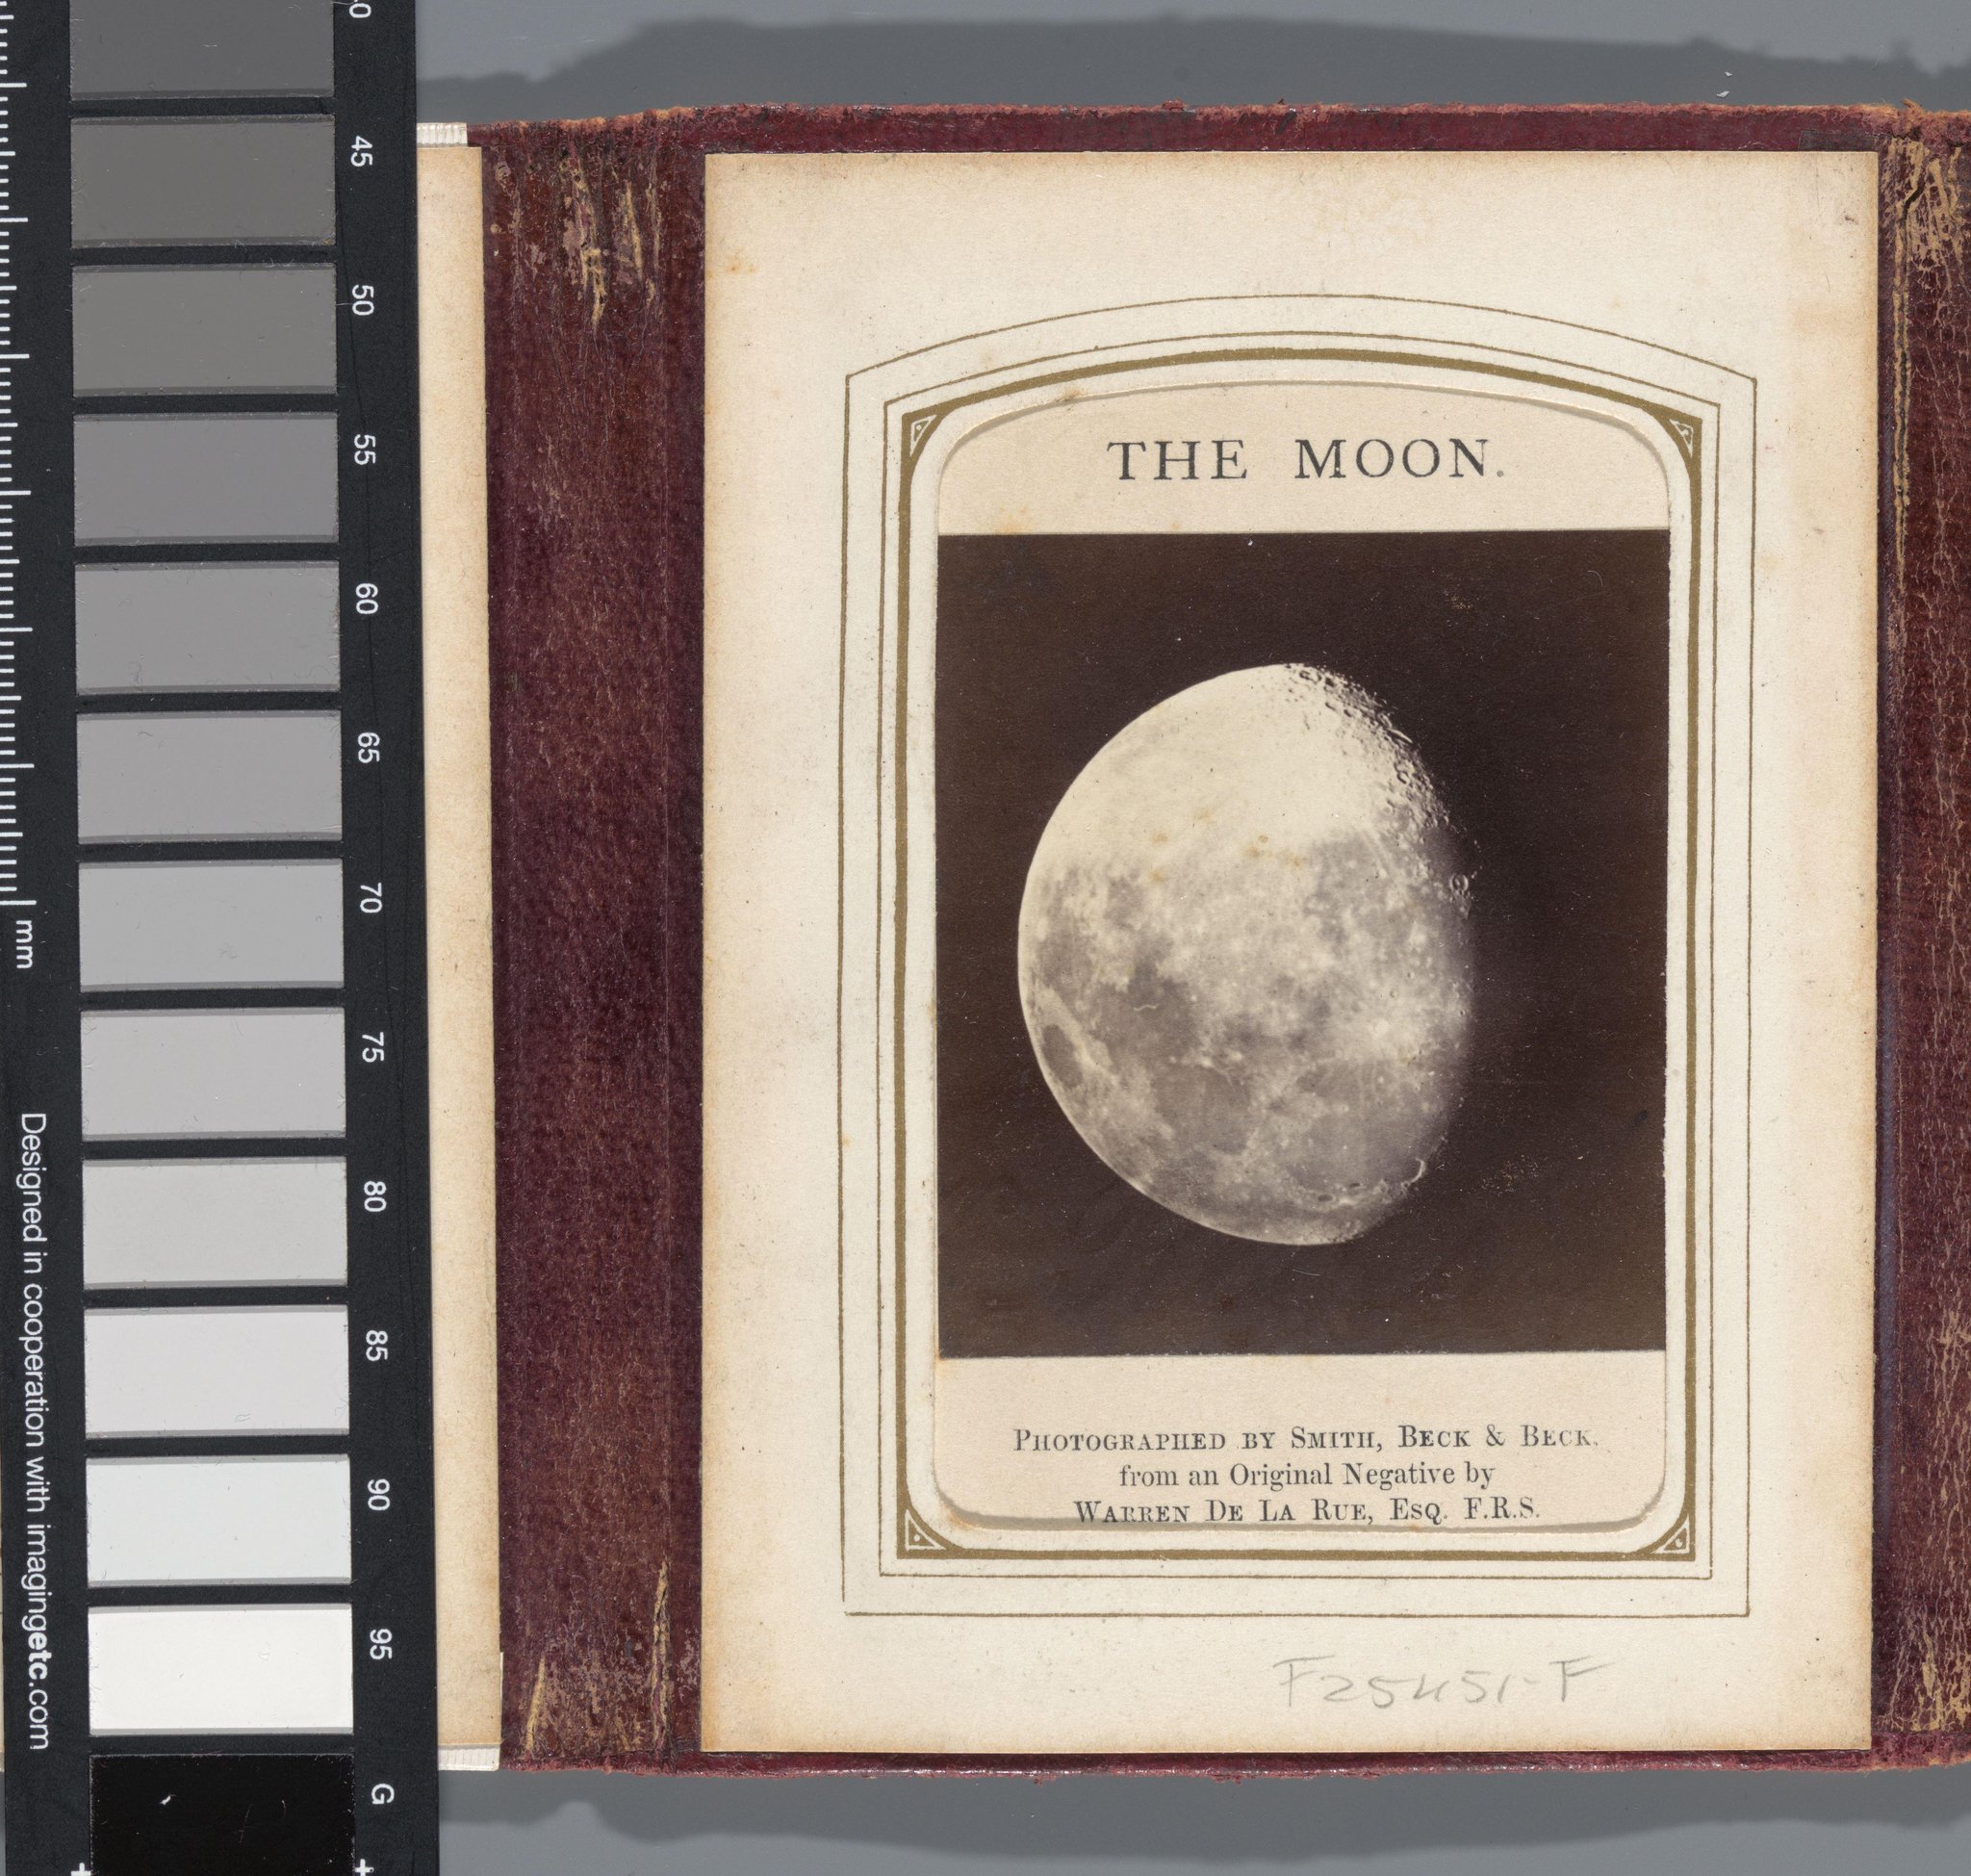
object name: album leaf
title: The Moon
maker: warren de la rue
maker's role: astronoom, fotograaf, scheikundige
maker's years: 1815-1889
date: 1866-1880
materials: cardboard, paper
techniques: albumen print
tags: waning moon, i.e. facing this way (, moon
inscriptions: inscription: ‘PHOTOGRAPHED BY SMITH, BECK & BECK,/ from an Original Negative by/WARREN DE LA RUE, ESQ, F.R.S.’